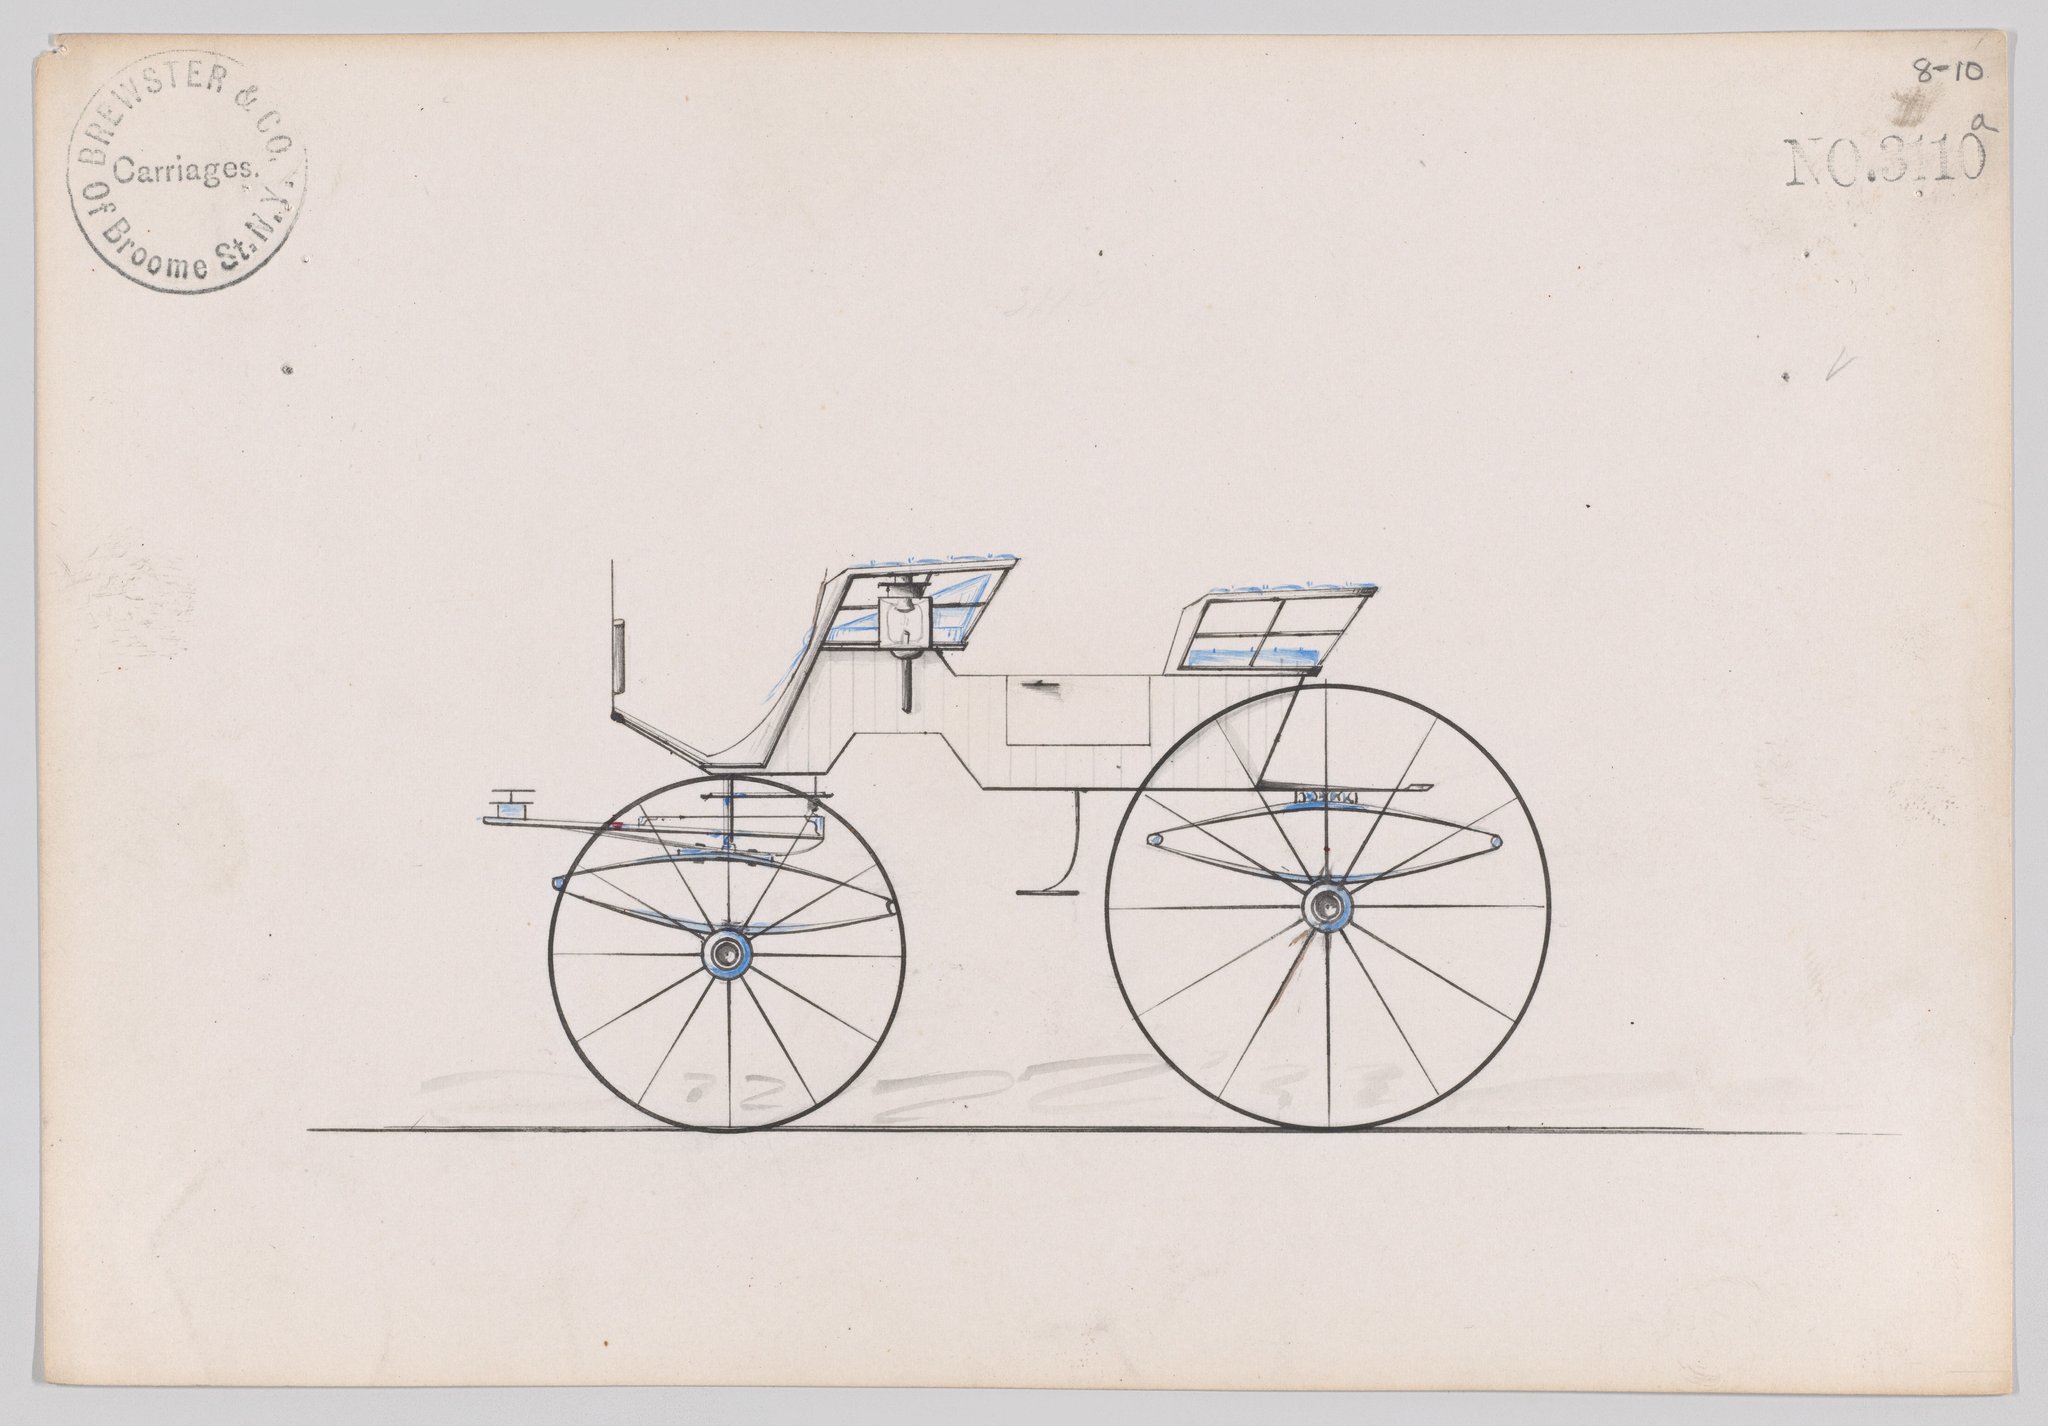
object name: drawing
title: Design for 4 seat Phaeton, no top, no. 3110a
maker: brewster & co.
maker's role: manufacturer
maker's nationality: american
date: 1875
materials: gouache, ink, watercolor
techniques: pen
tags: carriages